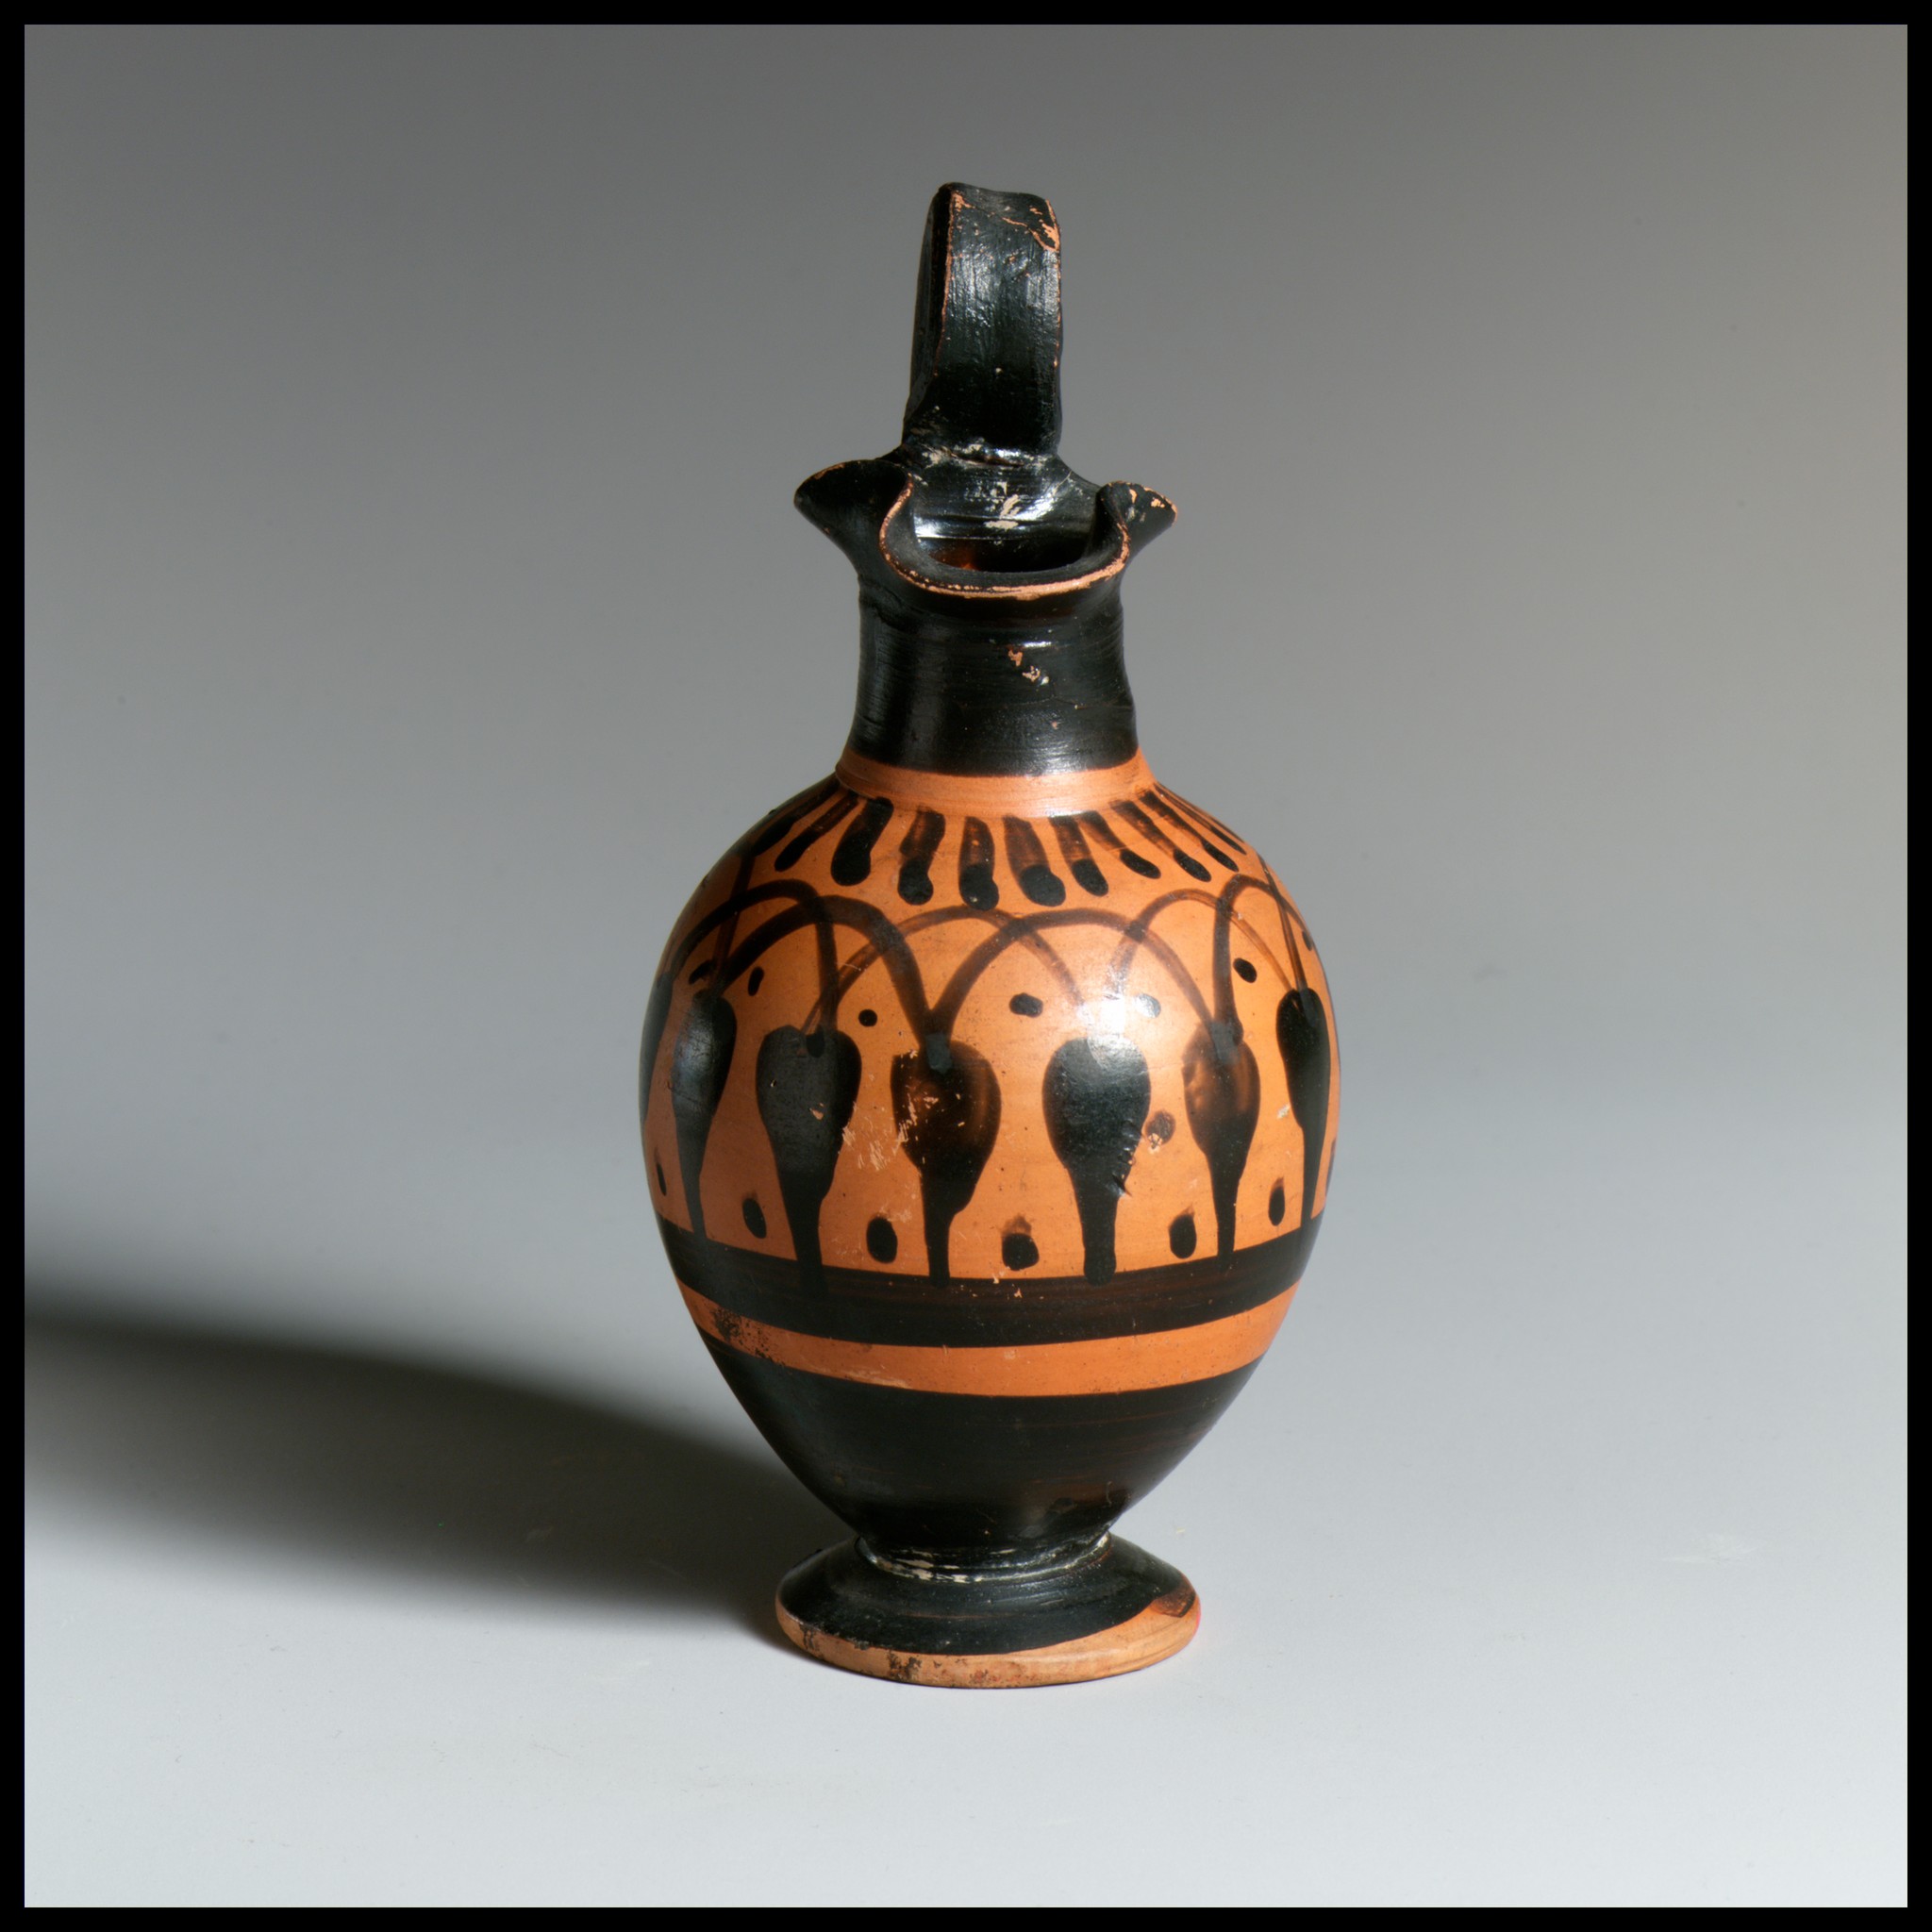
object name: oinochoe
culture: greek, attic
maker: dubois class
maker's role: artist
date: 600-501 BCE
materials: terracotta